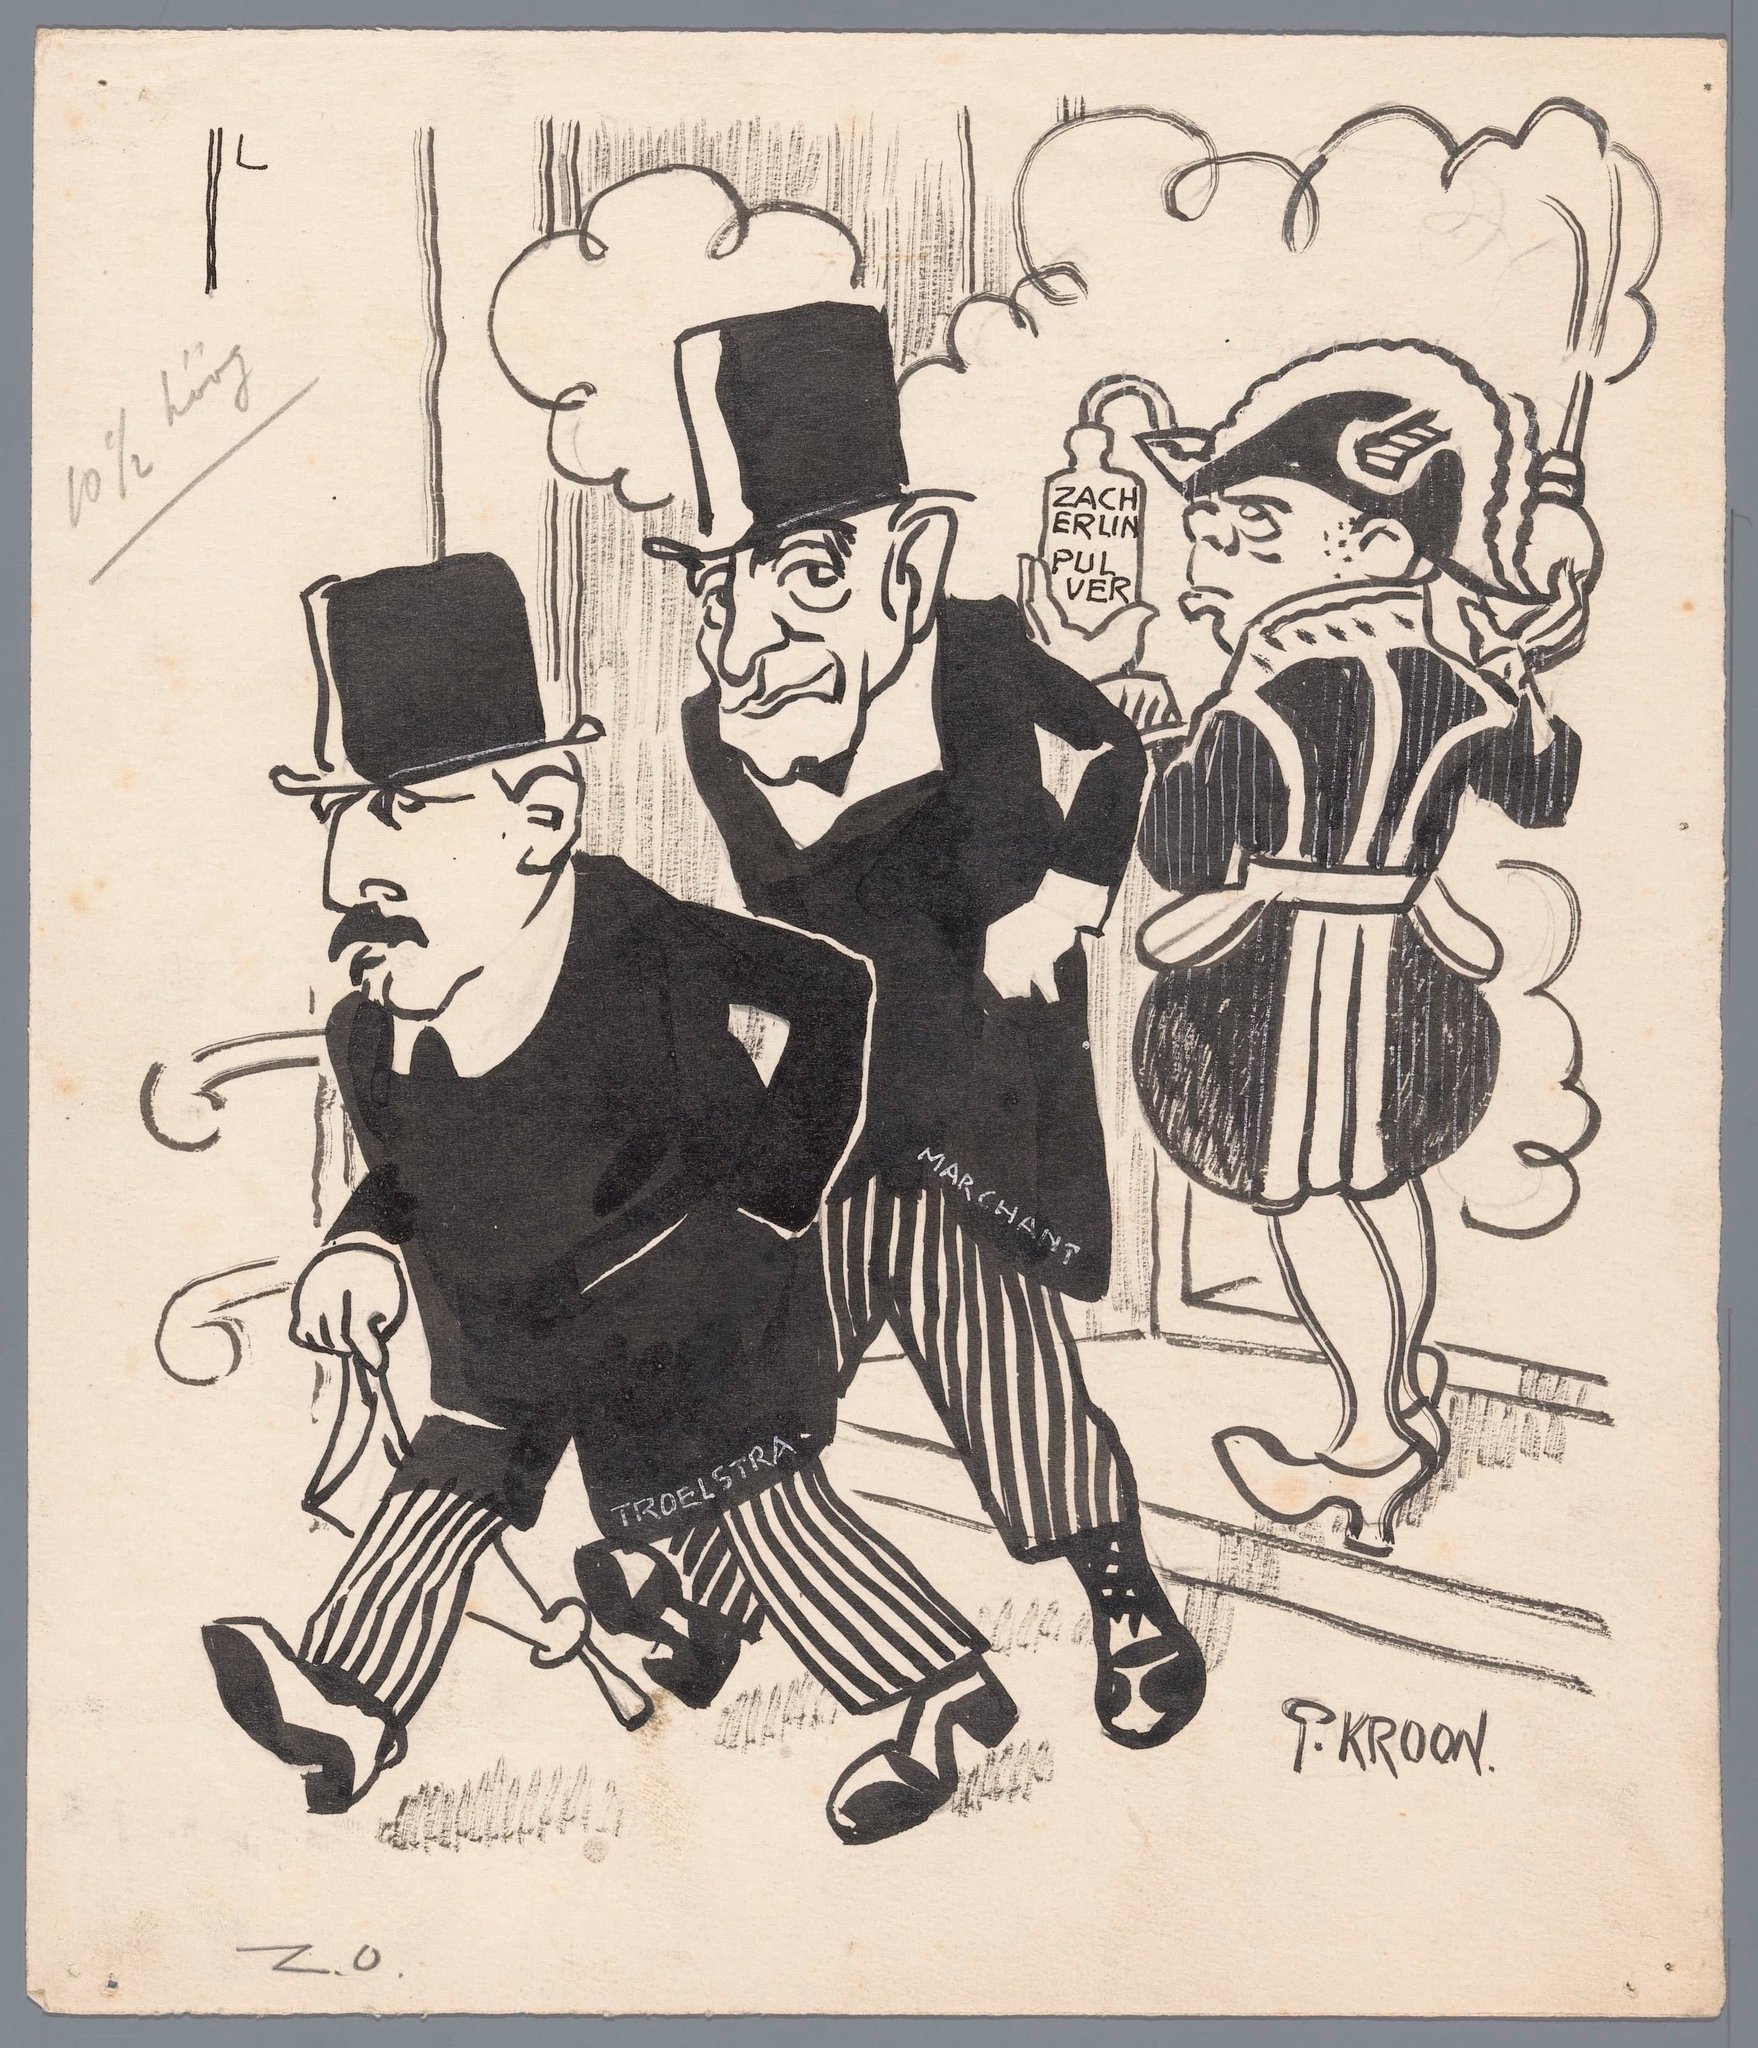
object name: cartoon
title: Troelstra en Marchant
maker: patricq kroon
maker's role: draughtsman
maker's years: 1862-1941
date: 1900-1930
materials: paper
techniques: brush, pen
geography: netherlands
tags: politician, using scents, perfumes, ointments, etc., political caricatures and satires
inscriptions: number: ‘14574’, inscription: ‘Democratie tenhove. De nestellakei: ... Extra uitluchten! ...’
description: Troelstra en Marchant verlaten het paleis terwijl een lakei parfum sproeit. Ontwerp voor een politieke spotprent.